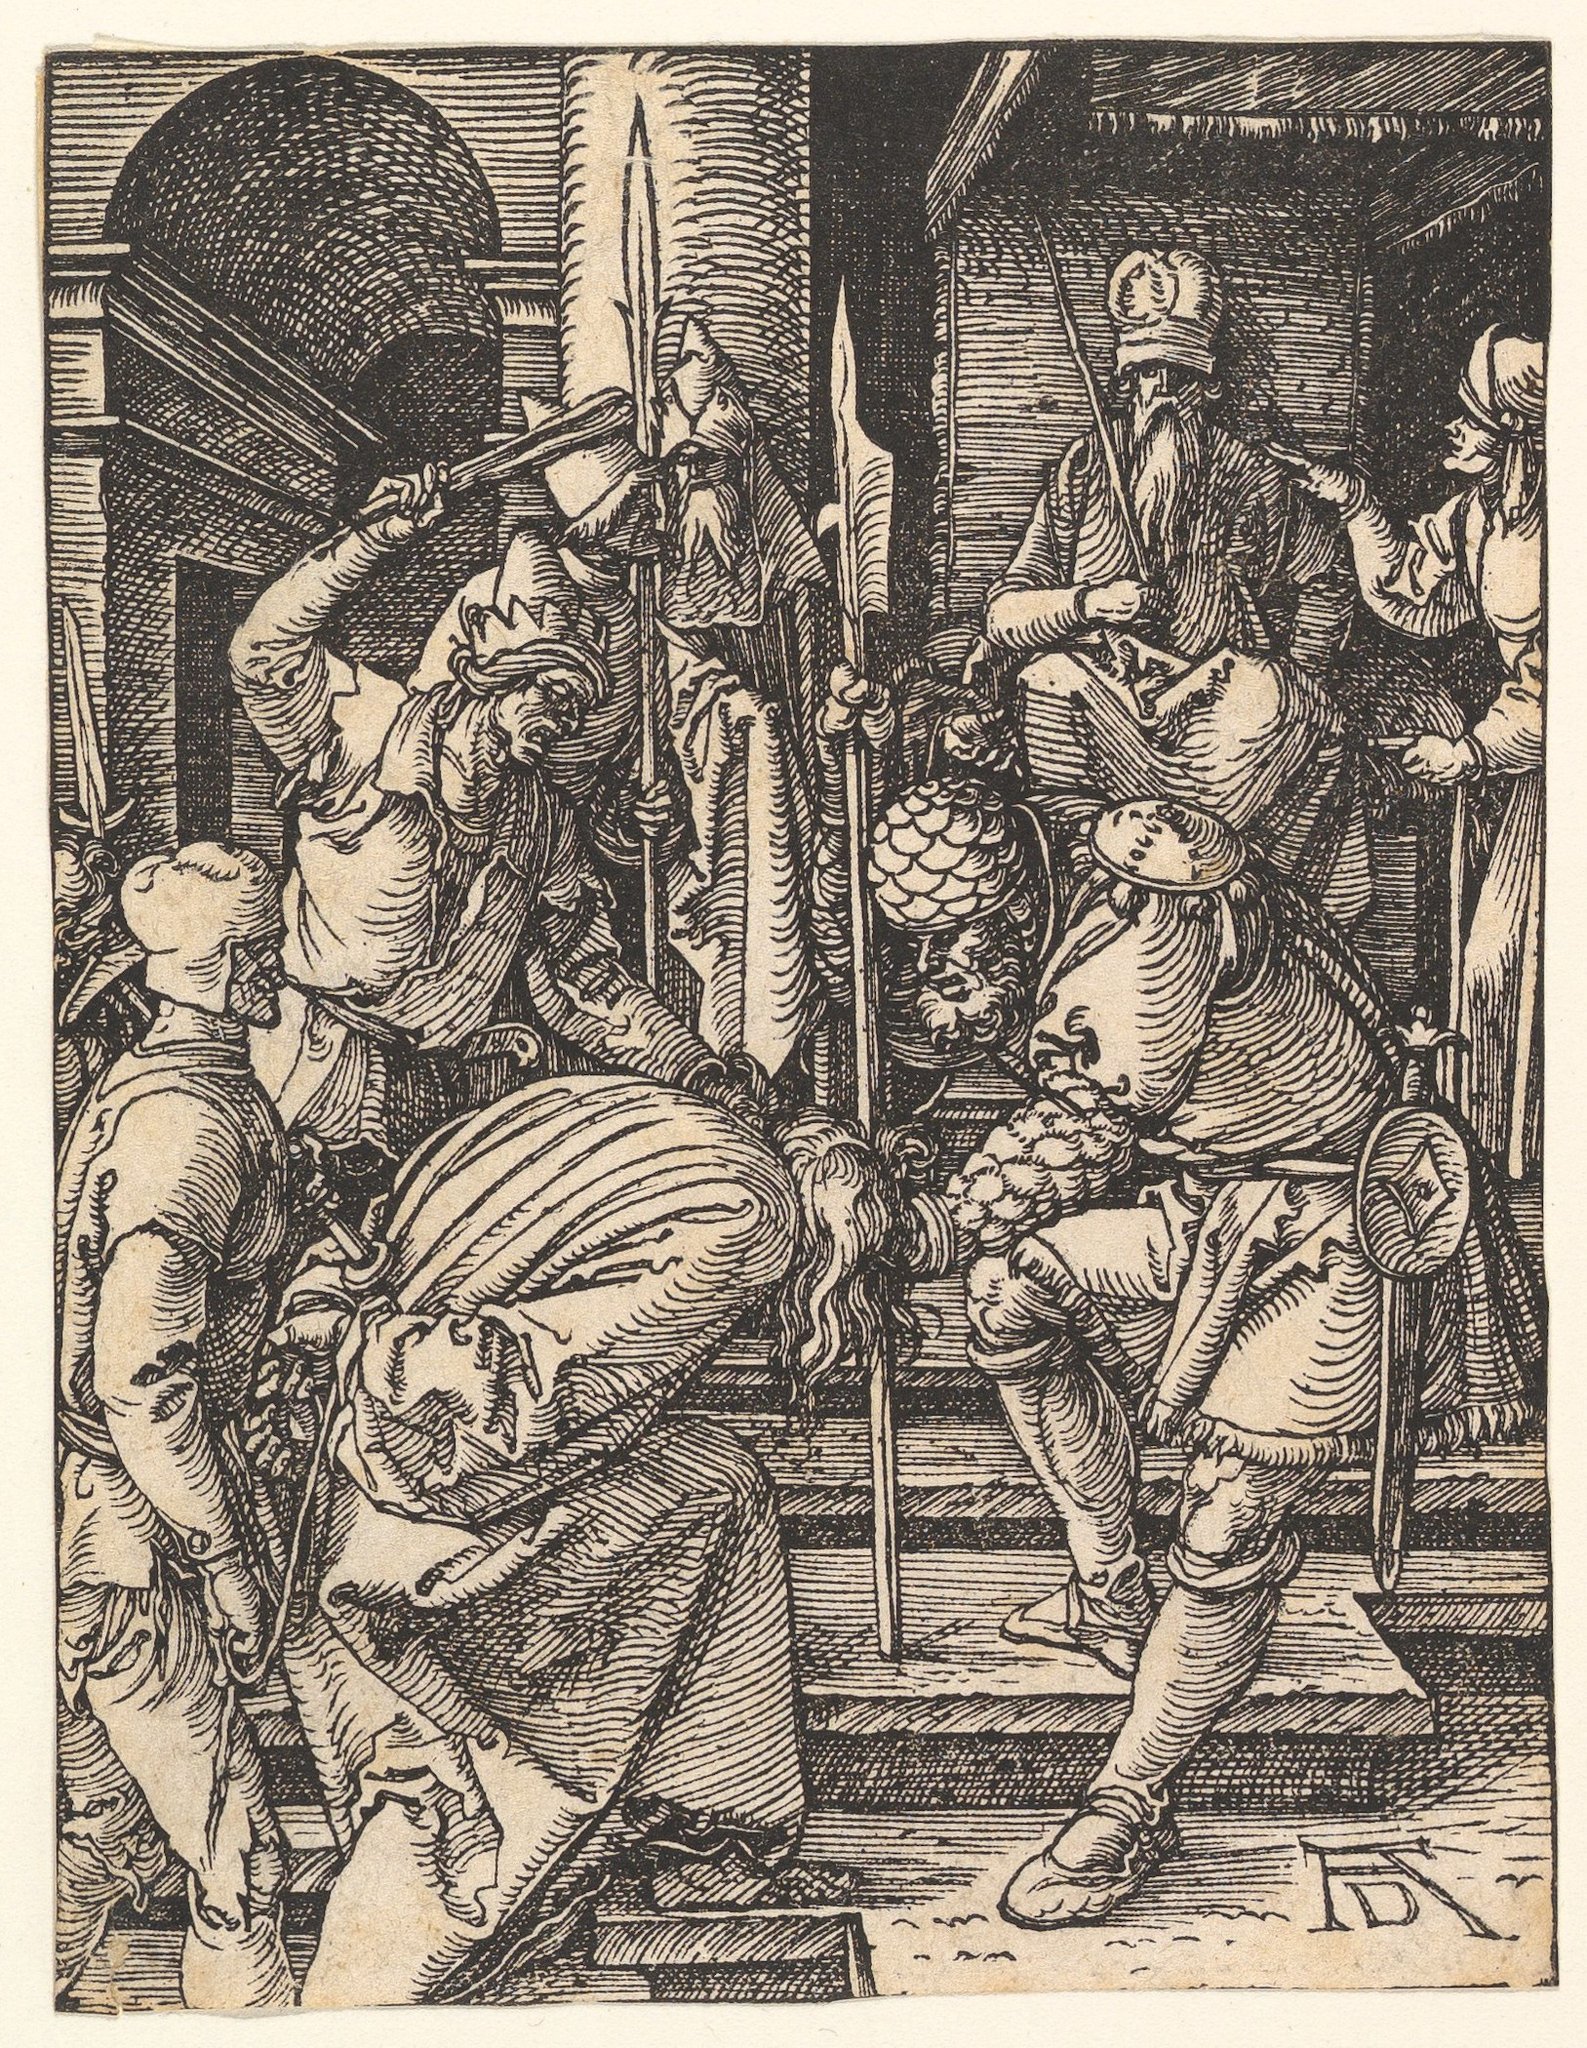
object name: print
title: Christ Before Annas, from "The Small Passion"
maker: albrecht dürer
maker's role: artist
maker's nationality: german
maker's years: 1471-1528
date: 1508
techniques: woodcut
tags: men,christ